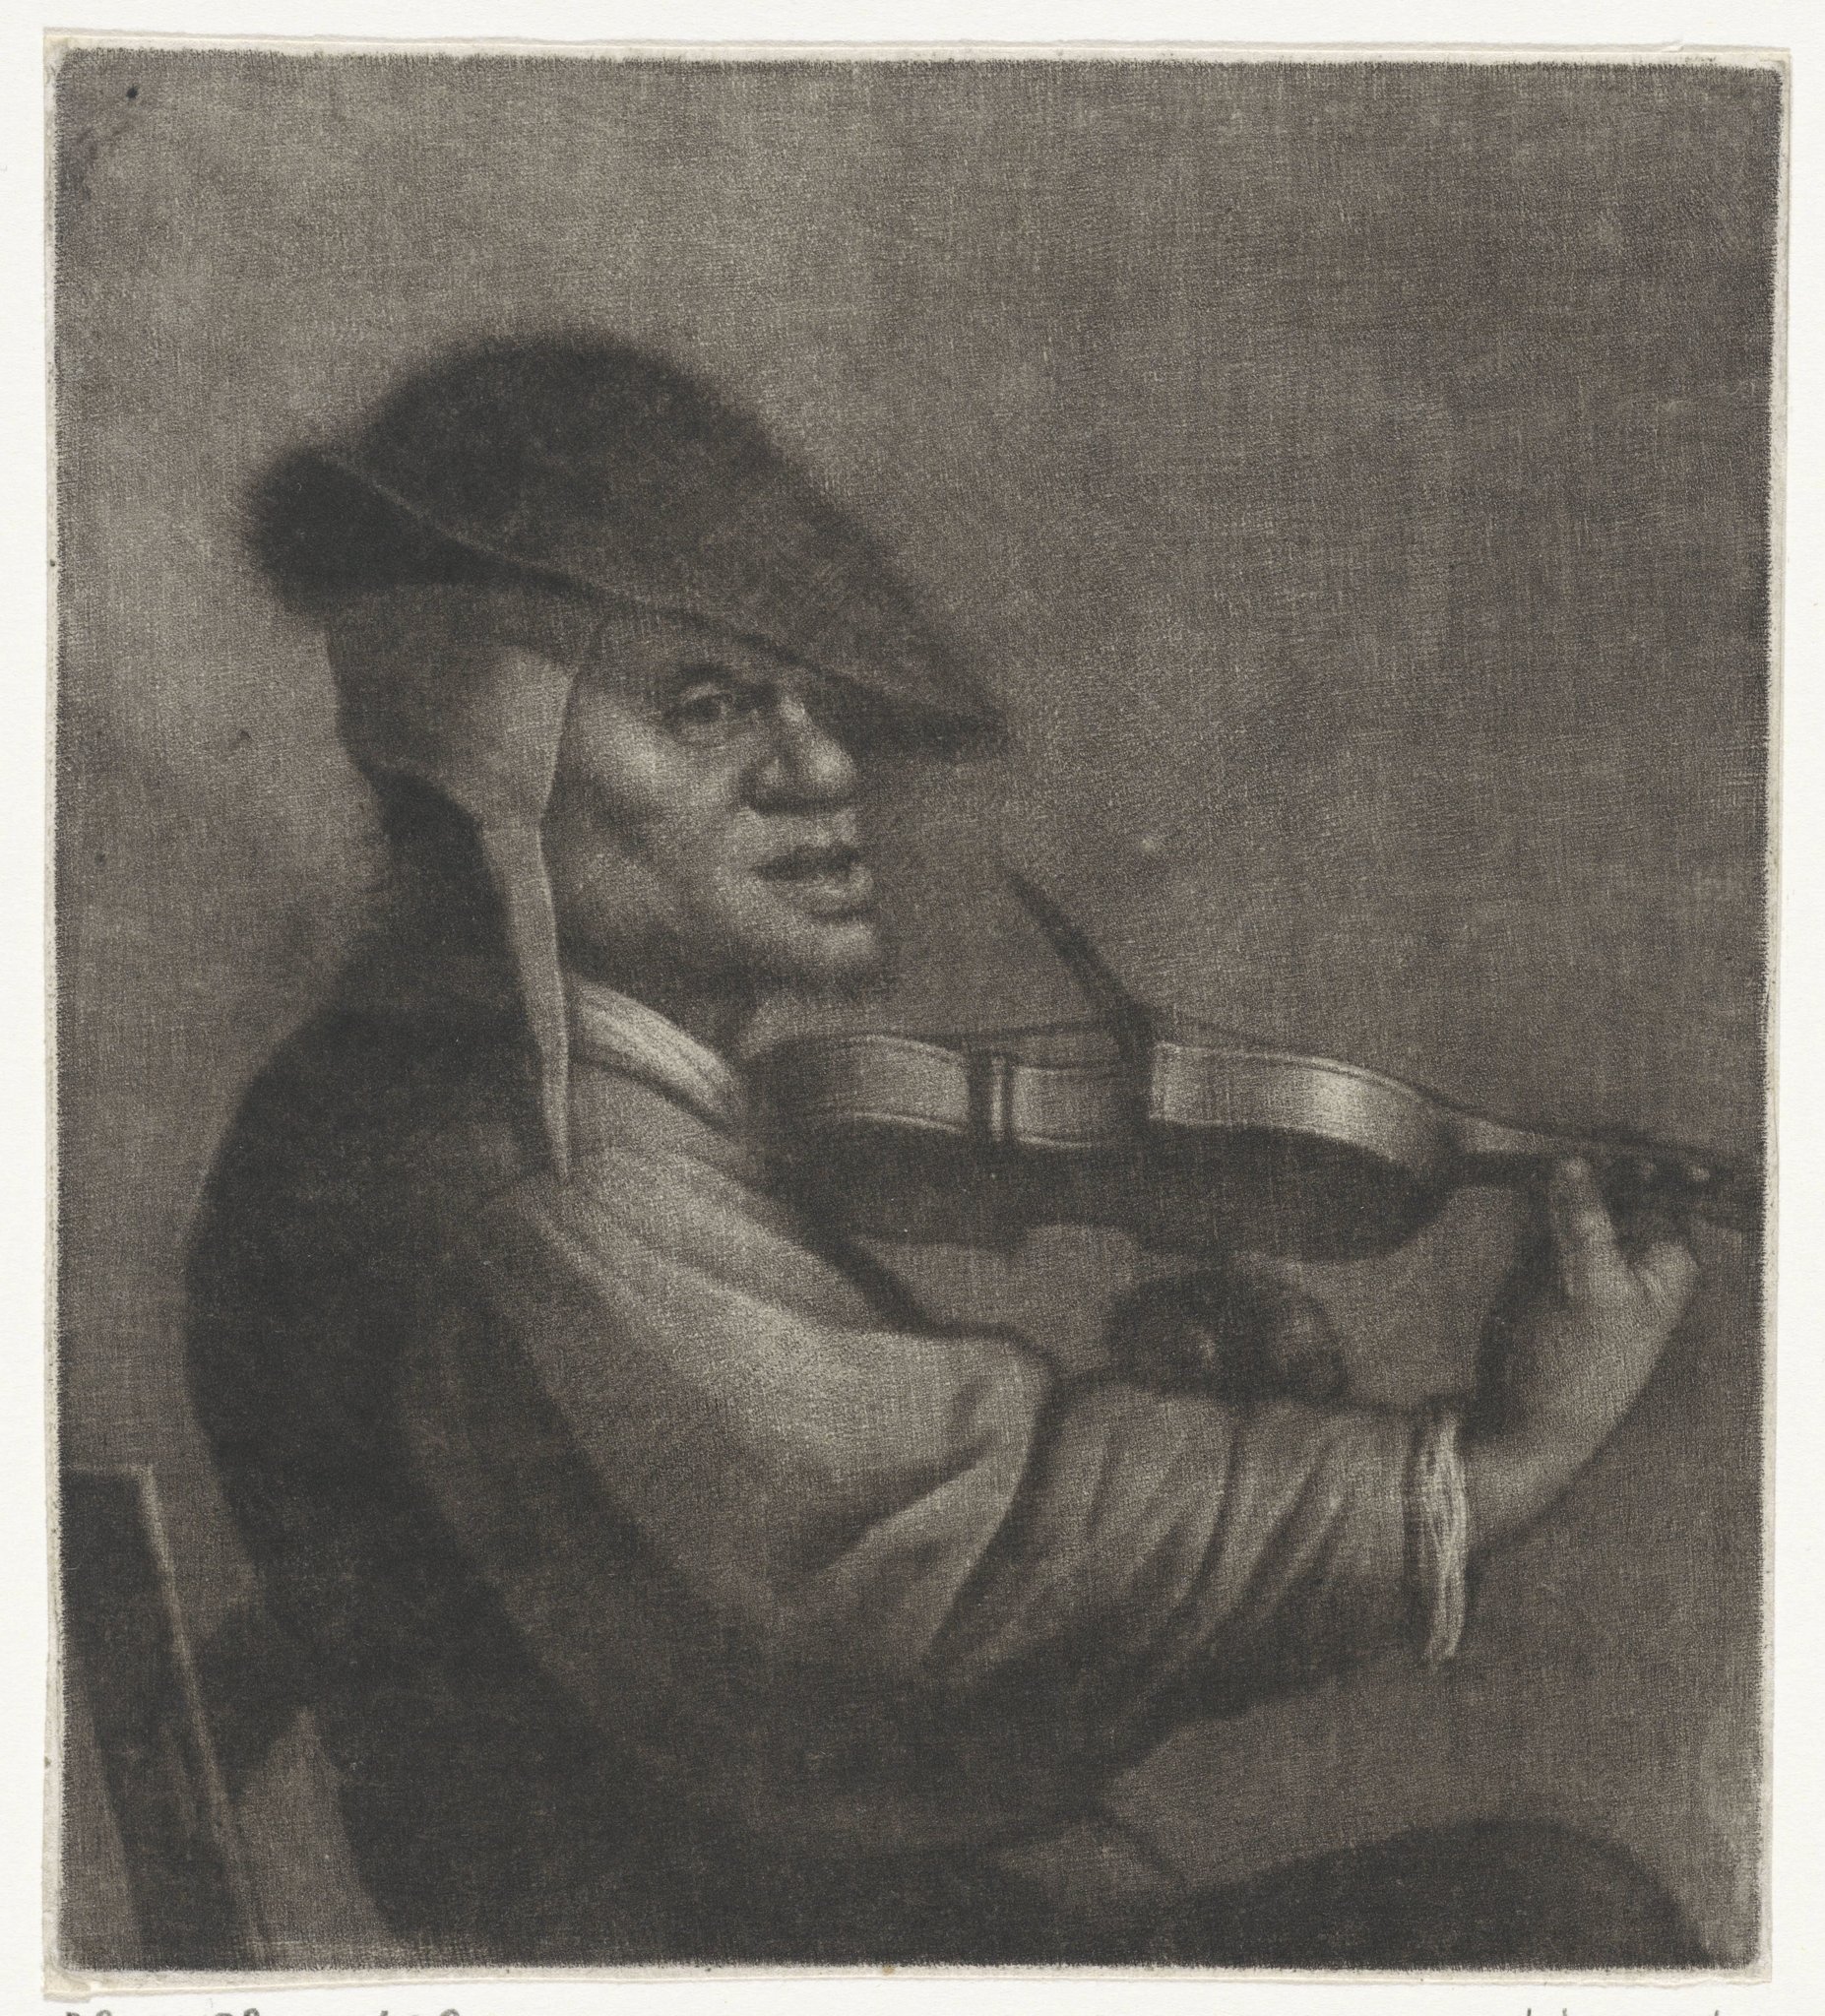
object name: print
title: Vioolspeler (het Gehoor)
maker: wallerant vaillant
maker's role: draughtsman, painter, print maker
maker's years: 1623-1677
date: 1658-1677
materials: paper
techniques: mezzotint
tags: hearing, listening (one of the five senses), one person playing string instrument (bowed)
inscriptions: collector's mark: Lugt 240